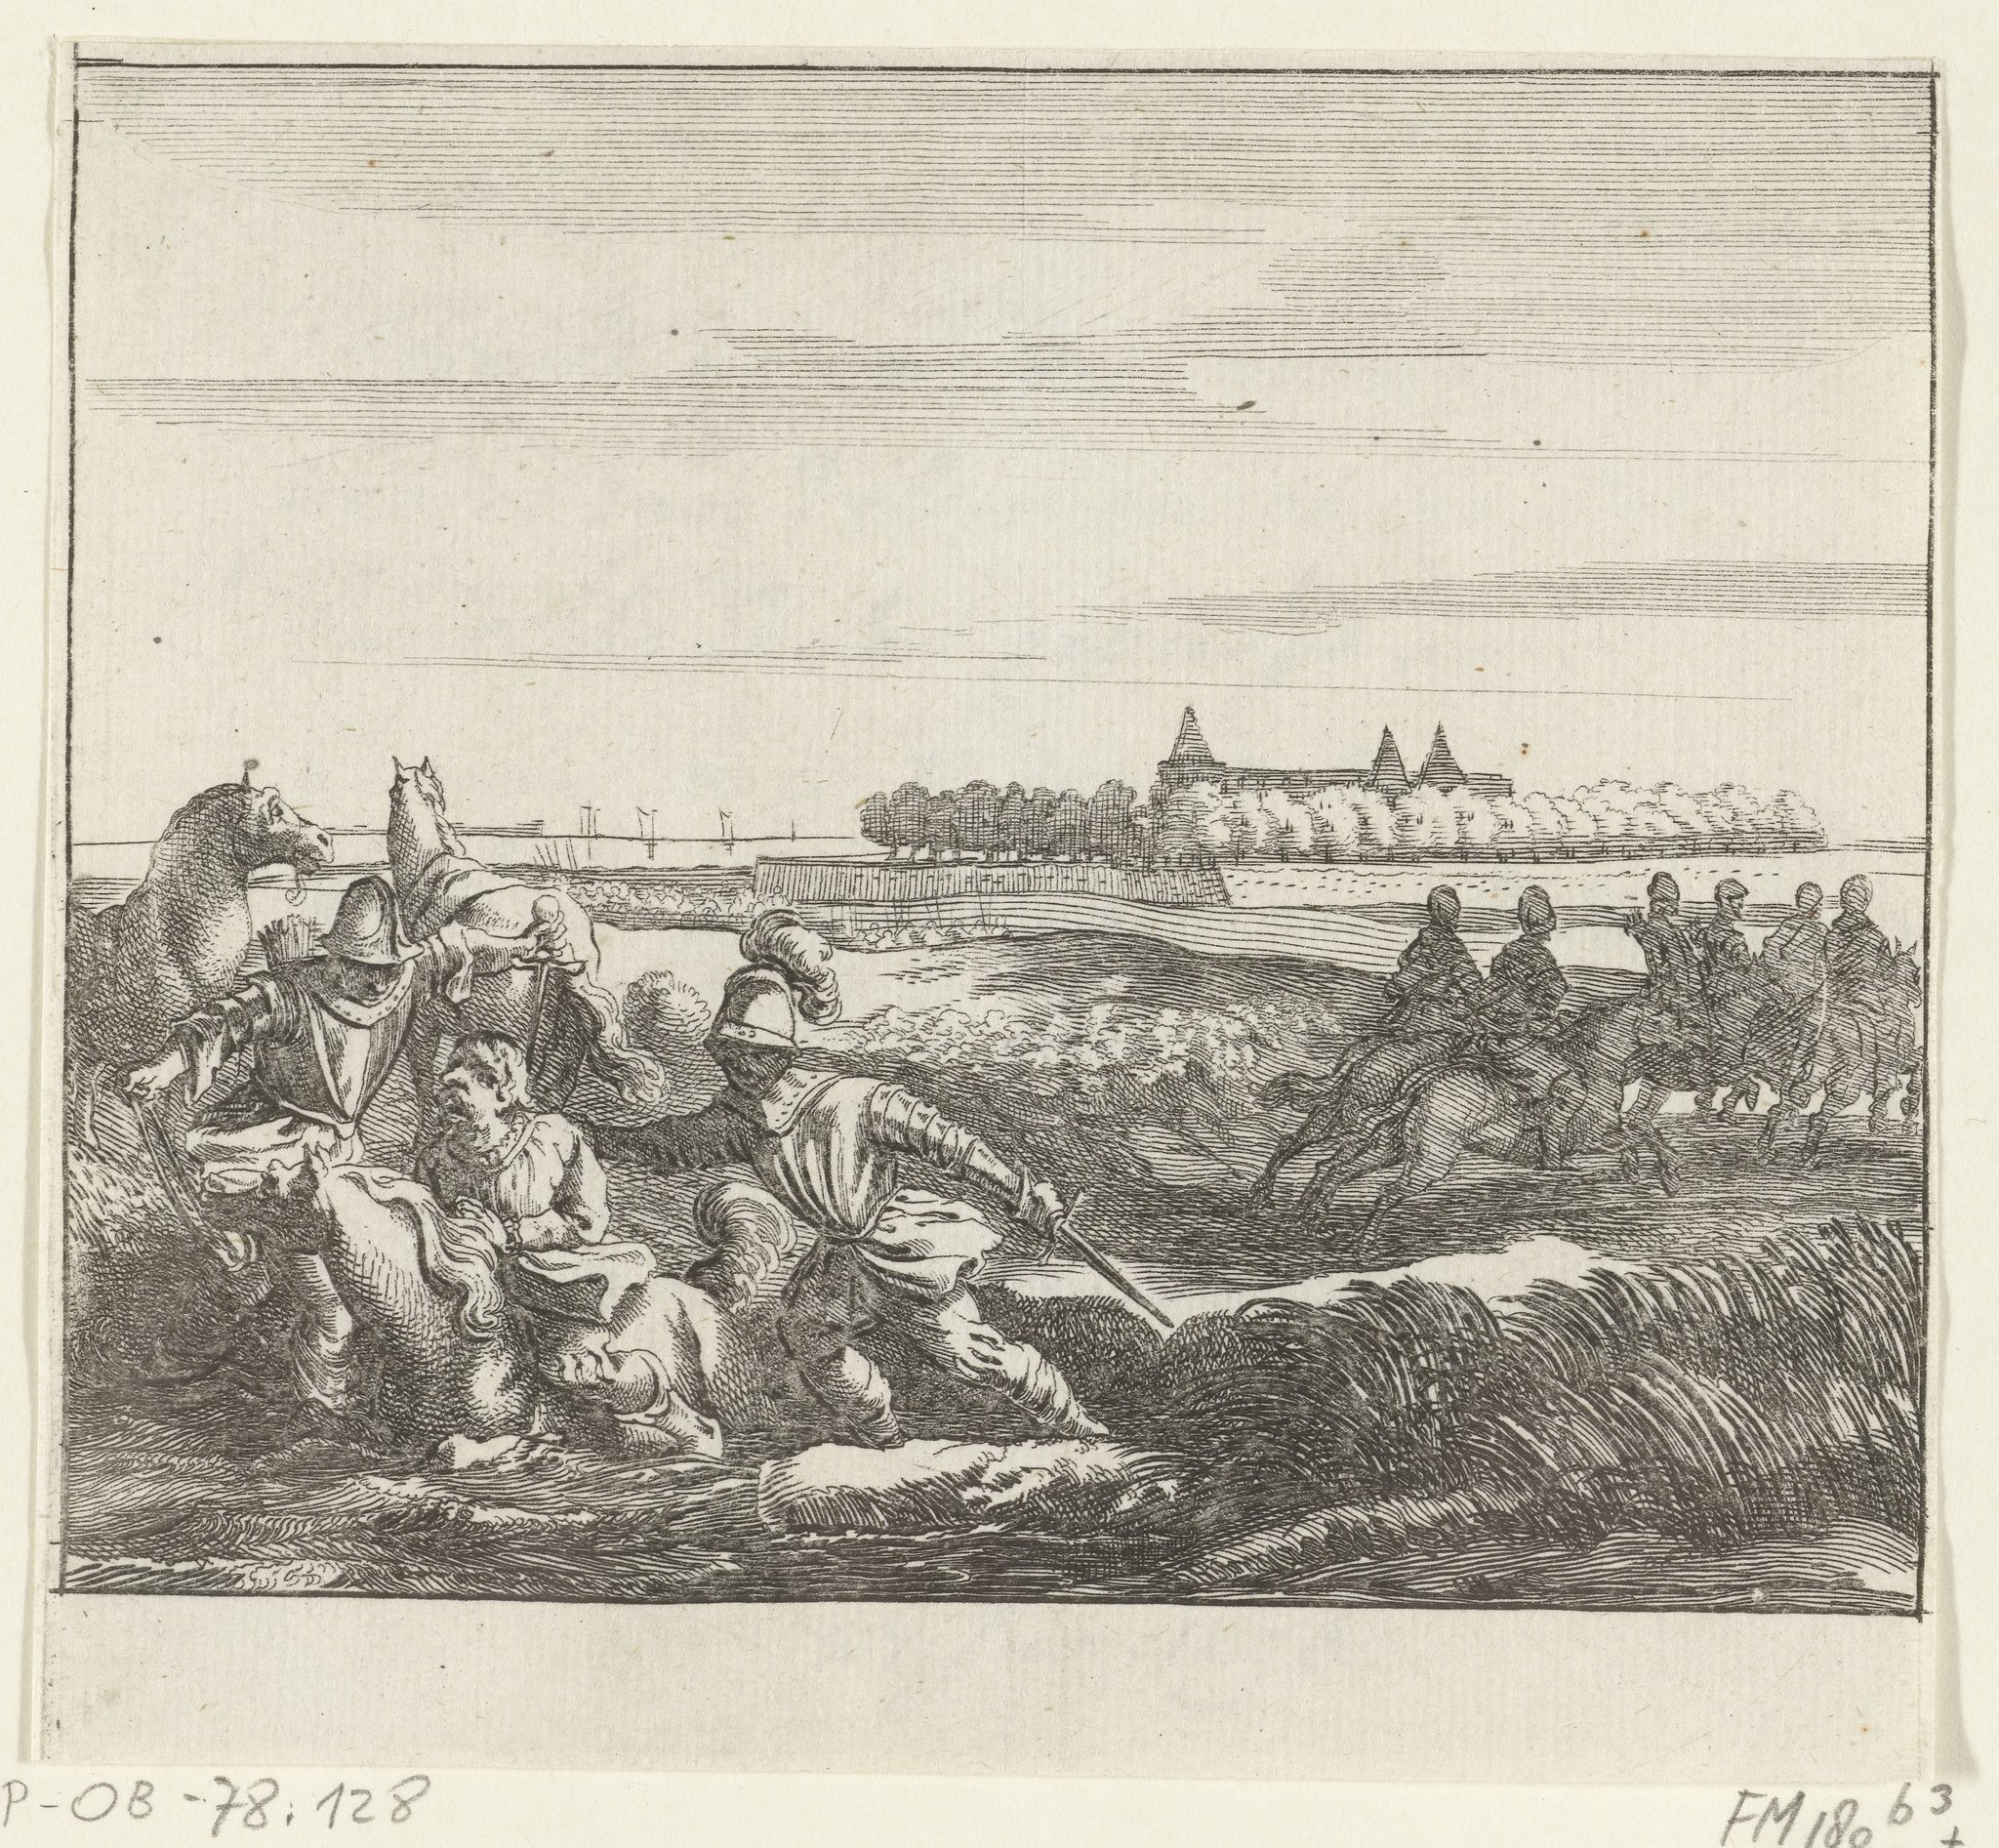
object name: print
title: Moord op Floris V, 1296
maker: Anonymous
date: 1664-1699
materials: paper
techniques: engraving, etching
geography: northern netherlands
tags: floris v (graaf van holland en zeeland), violent death, being killed; being mishandled and maltreated; seeking death, netherlands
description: Kopie naar de illustratie voor: A. Montanus, Beschrijvinge der eerste inwoonders van Aemstellandt, Marcus Willemsz. Doornik, Amsterdam 1664. Bij de prent een blad met beschrijving van de gebeurtenis in handschrift.